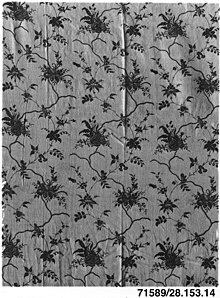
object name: floral print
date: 1767-1800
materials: cotton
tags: flowers